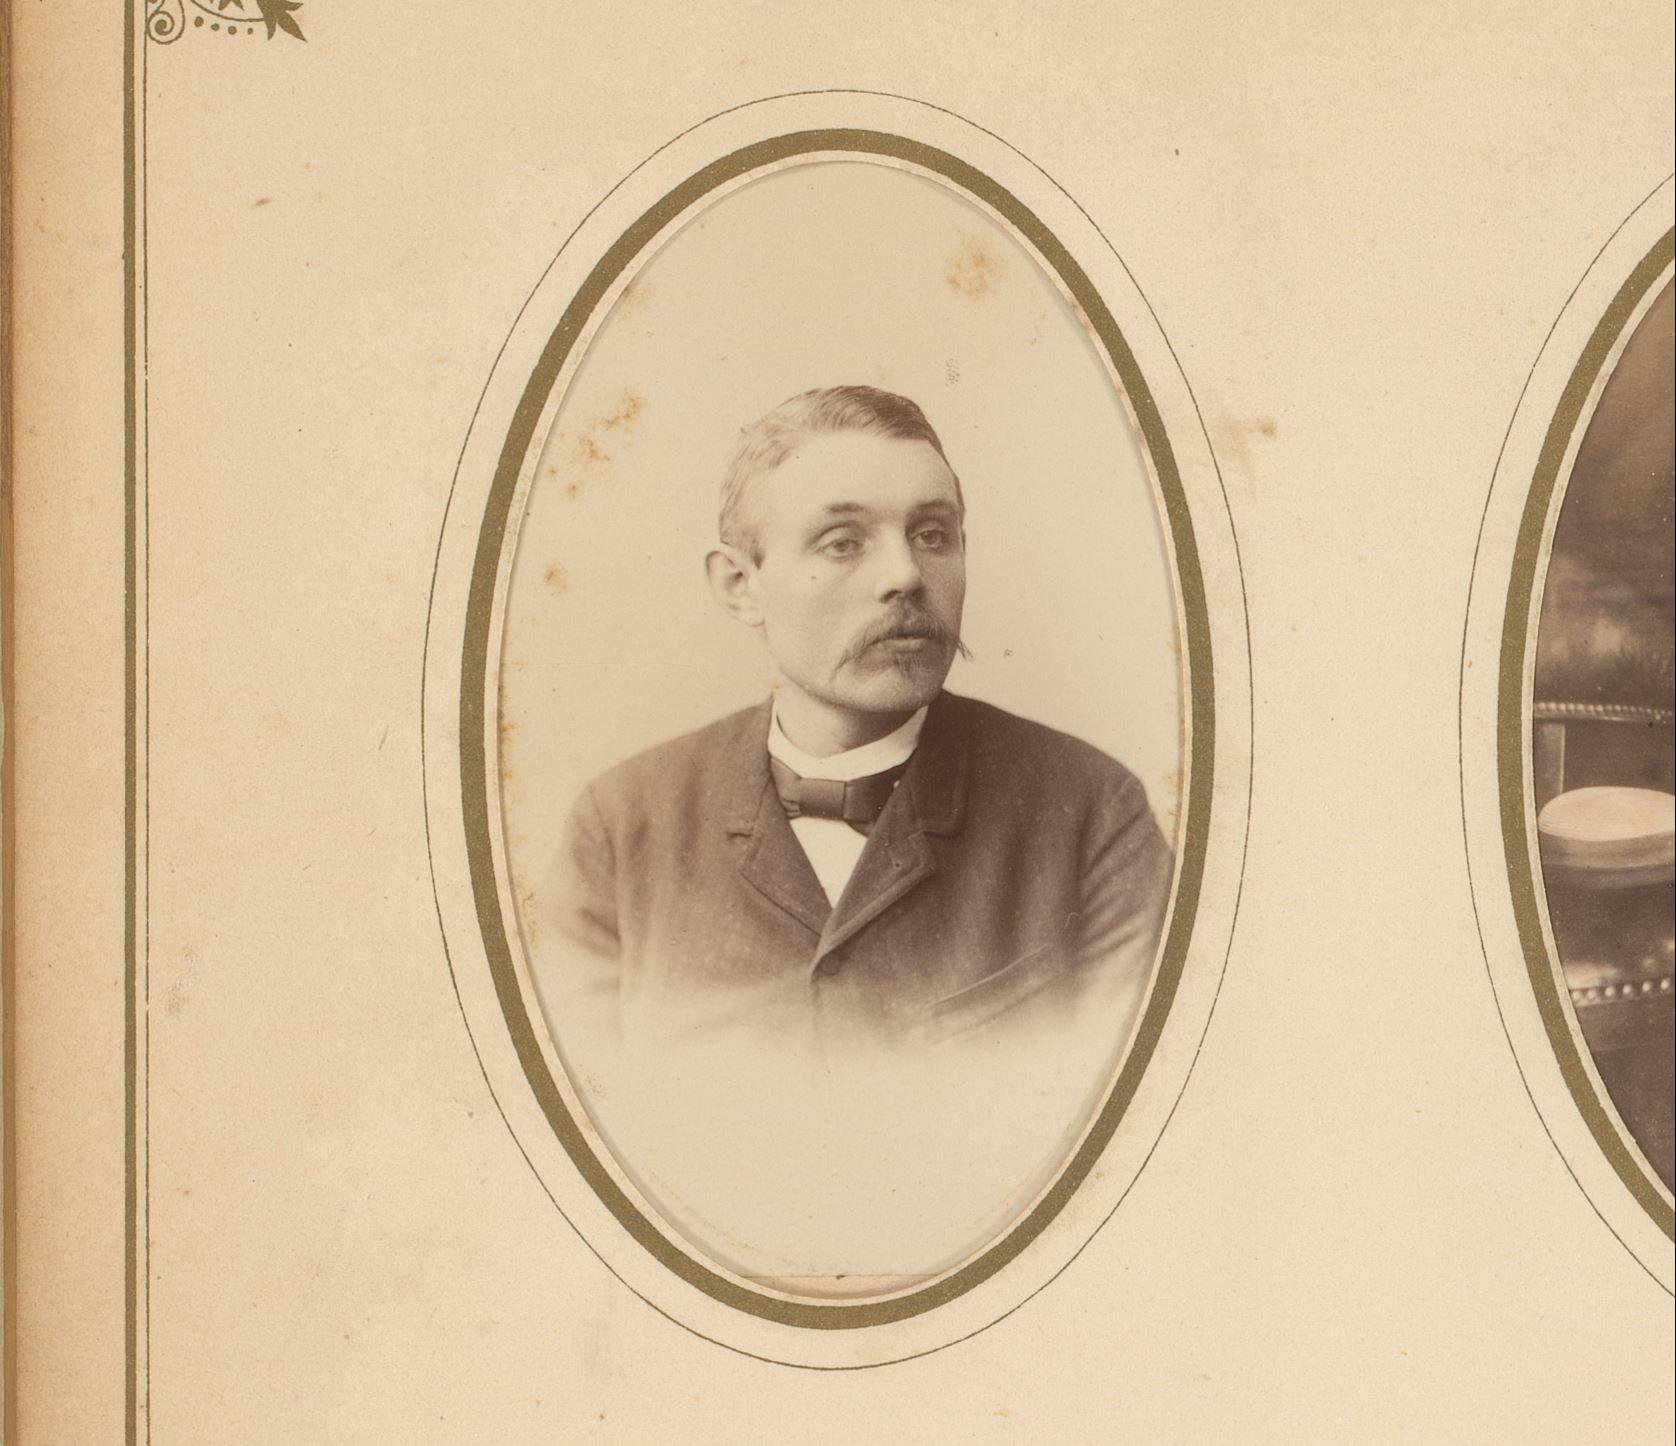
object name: album leaf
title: Portret van een man met snor en vlinderstrik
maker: albert greiner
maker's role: fotograaf, fotostudio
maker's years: 1833-1890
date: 1874-1887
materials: cardboard, photographic support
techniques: albumen print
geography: amsterdam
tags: moustache, historical persons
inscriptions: inscription: ‘(...)/ ALBERT GREINER/ KON. NED. HOF-PHOTOGRAAF/ AMSTERDAM/ NIEUWENDIJK 89./ Specialiteit in Vergrootingen.’